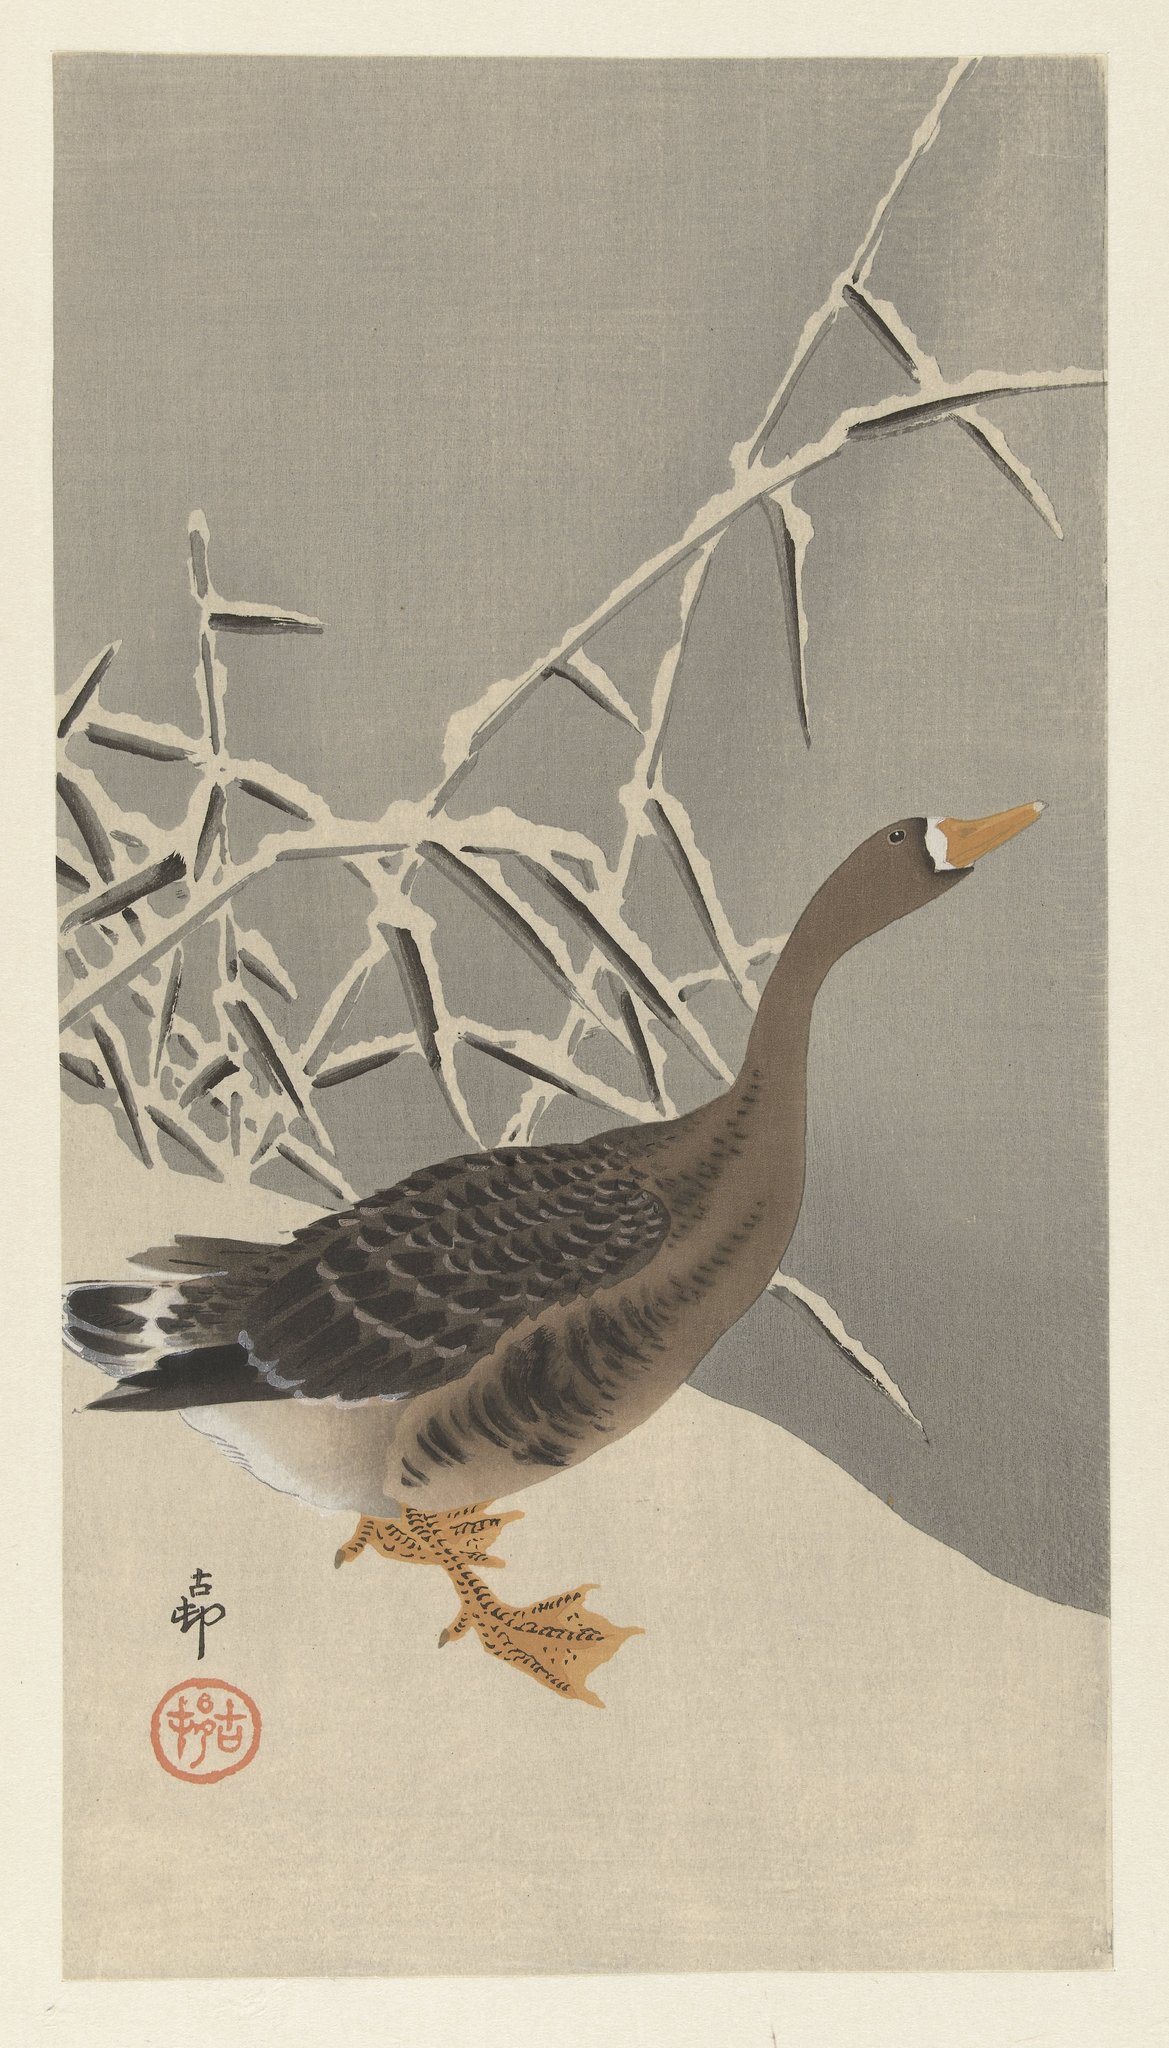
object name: print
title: White-fronted goose in snow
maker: ohara koson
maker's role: print maker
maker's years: 1877-1945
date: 1900-1930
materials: paper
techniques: woodcut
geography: tokyo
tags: water-birds: goose, plants and herbs: reed, snow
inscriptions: collector's mark: Lugt 2228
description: Gans bij besneeuwd riet; tegen grijze achtergrond.